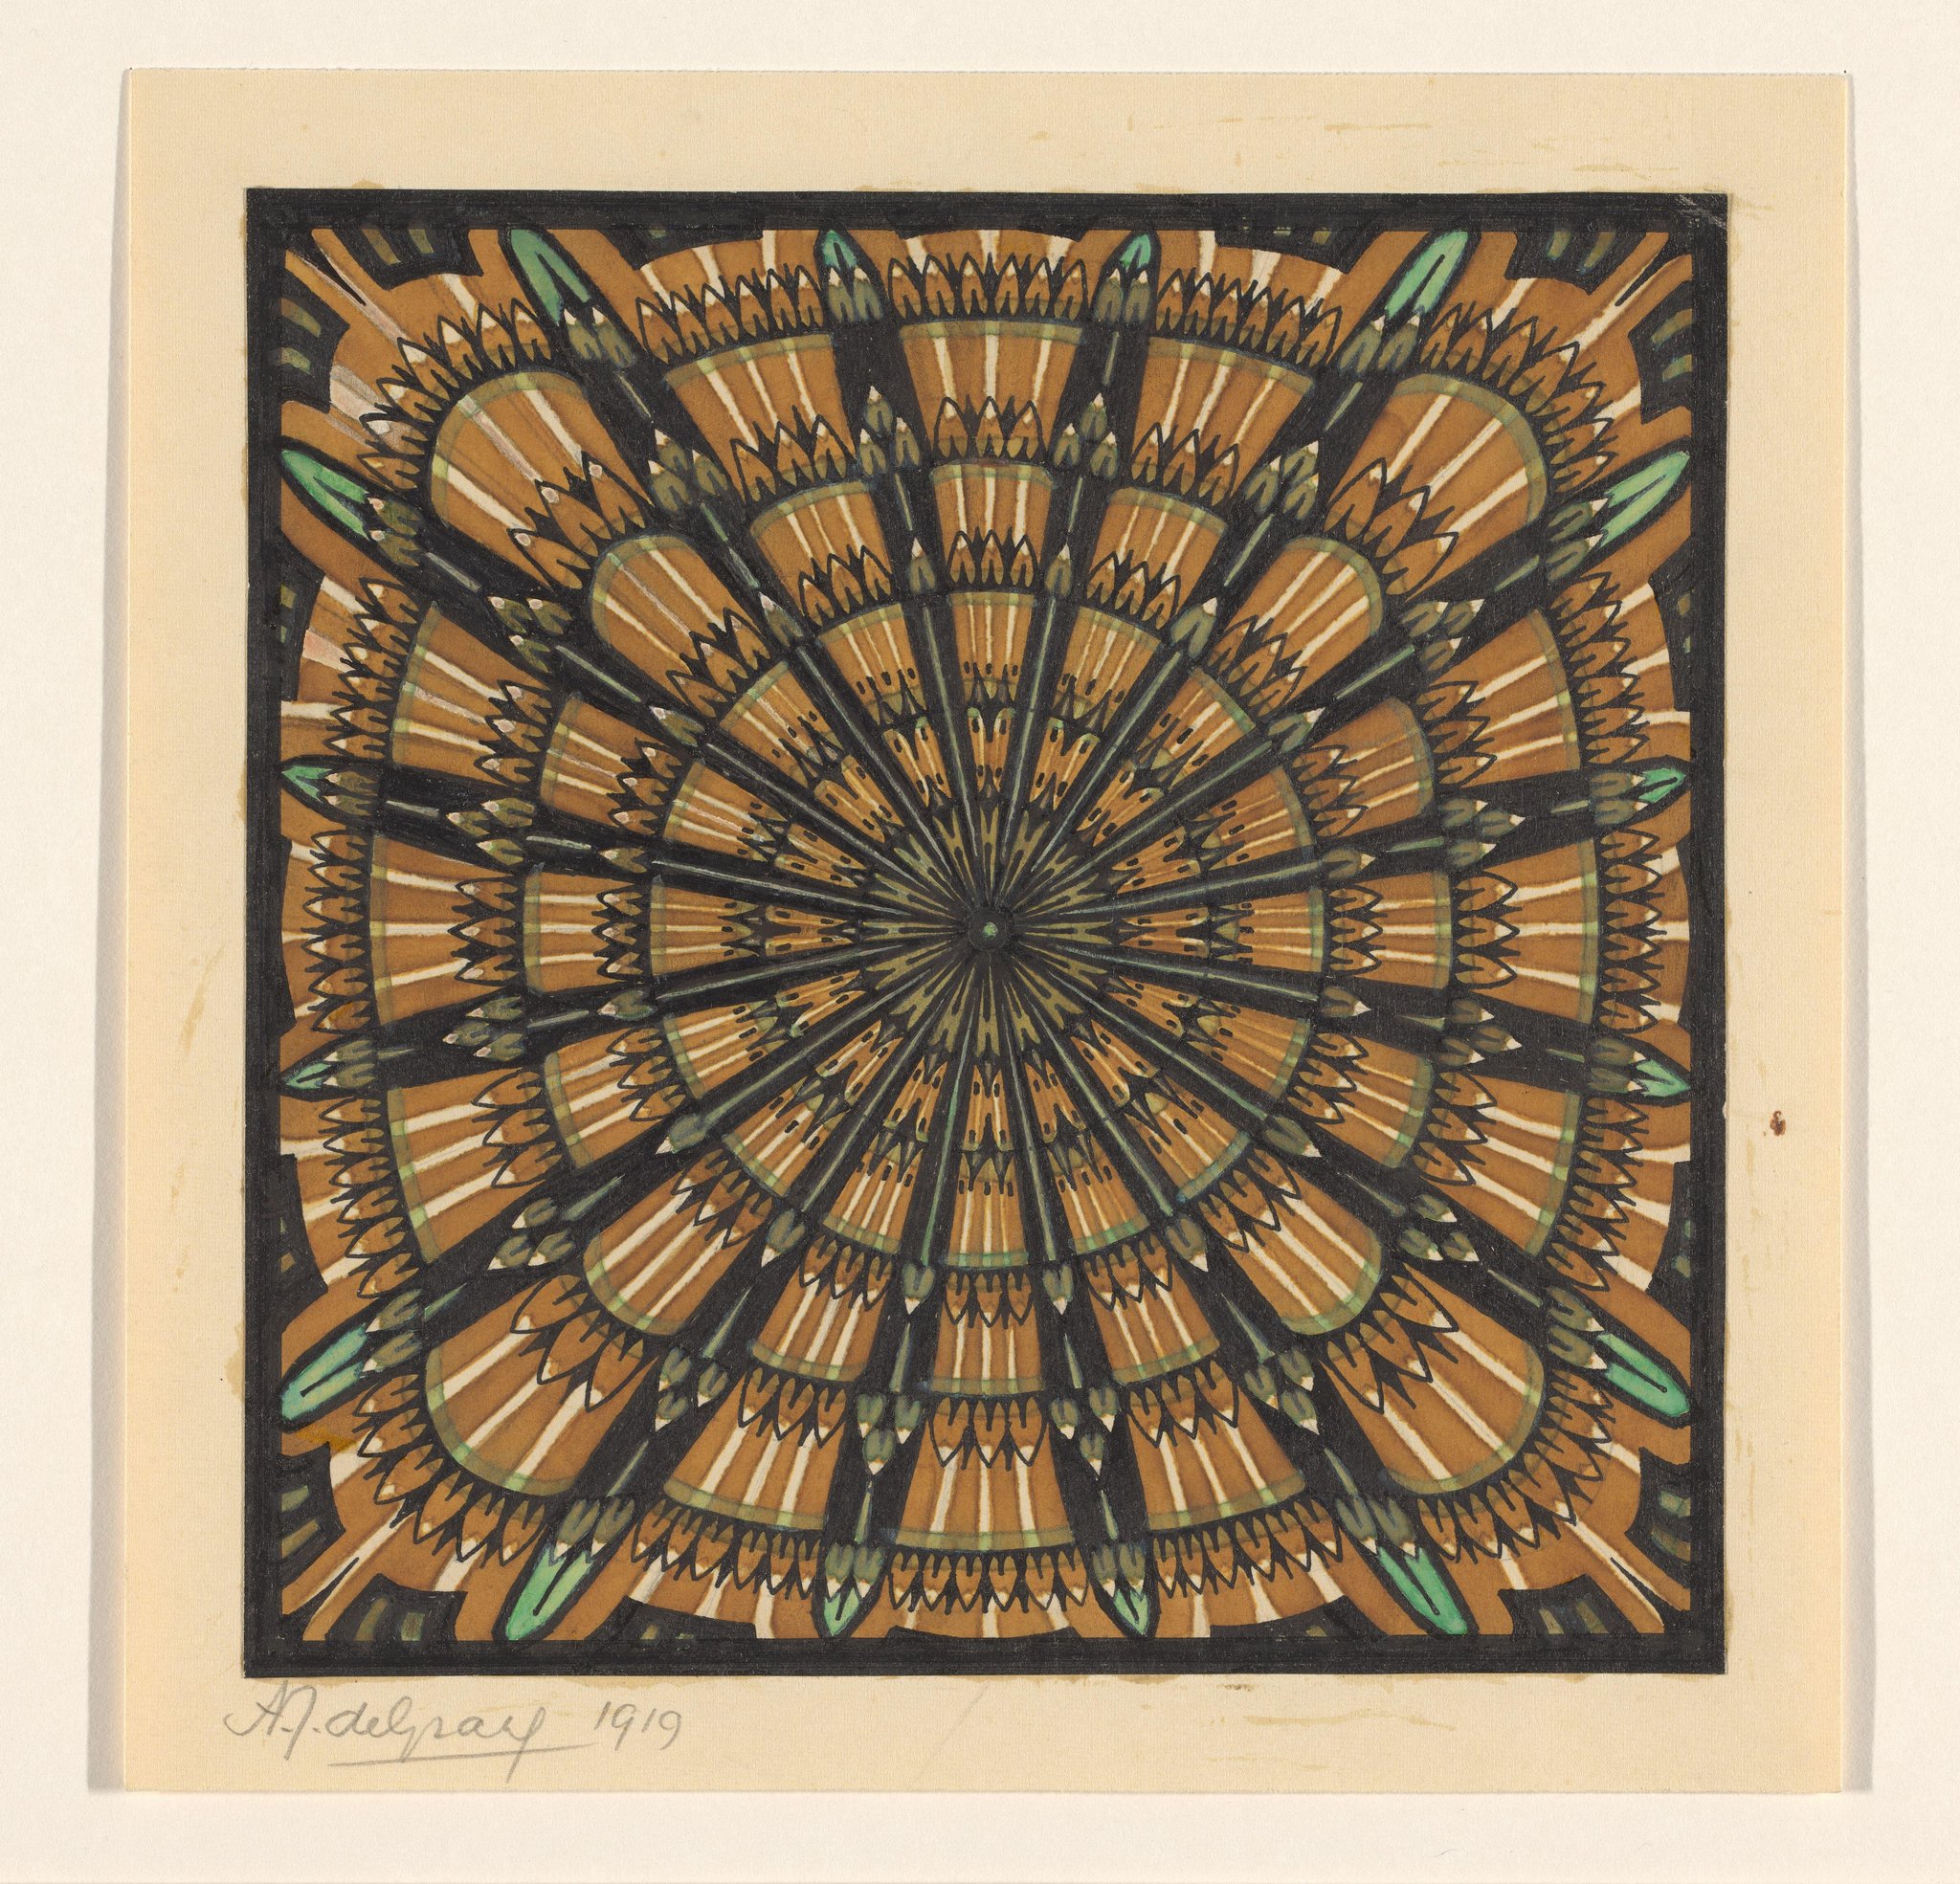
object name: drawing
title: Ontwerp voor een vierkant kleed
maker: julie de graag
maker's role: draughtsman, print maker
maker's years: 1877-1924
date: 1919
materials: paint, ink, paper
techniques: brush, pen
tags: ornaments ~ art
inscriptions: number: ‘183.’